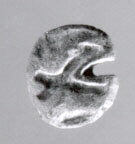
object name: stamp seal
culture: bactria-margiana archaeological complex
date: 2333-1668 BCE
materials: copper alloy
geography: bactria-margiana